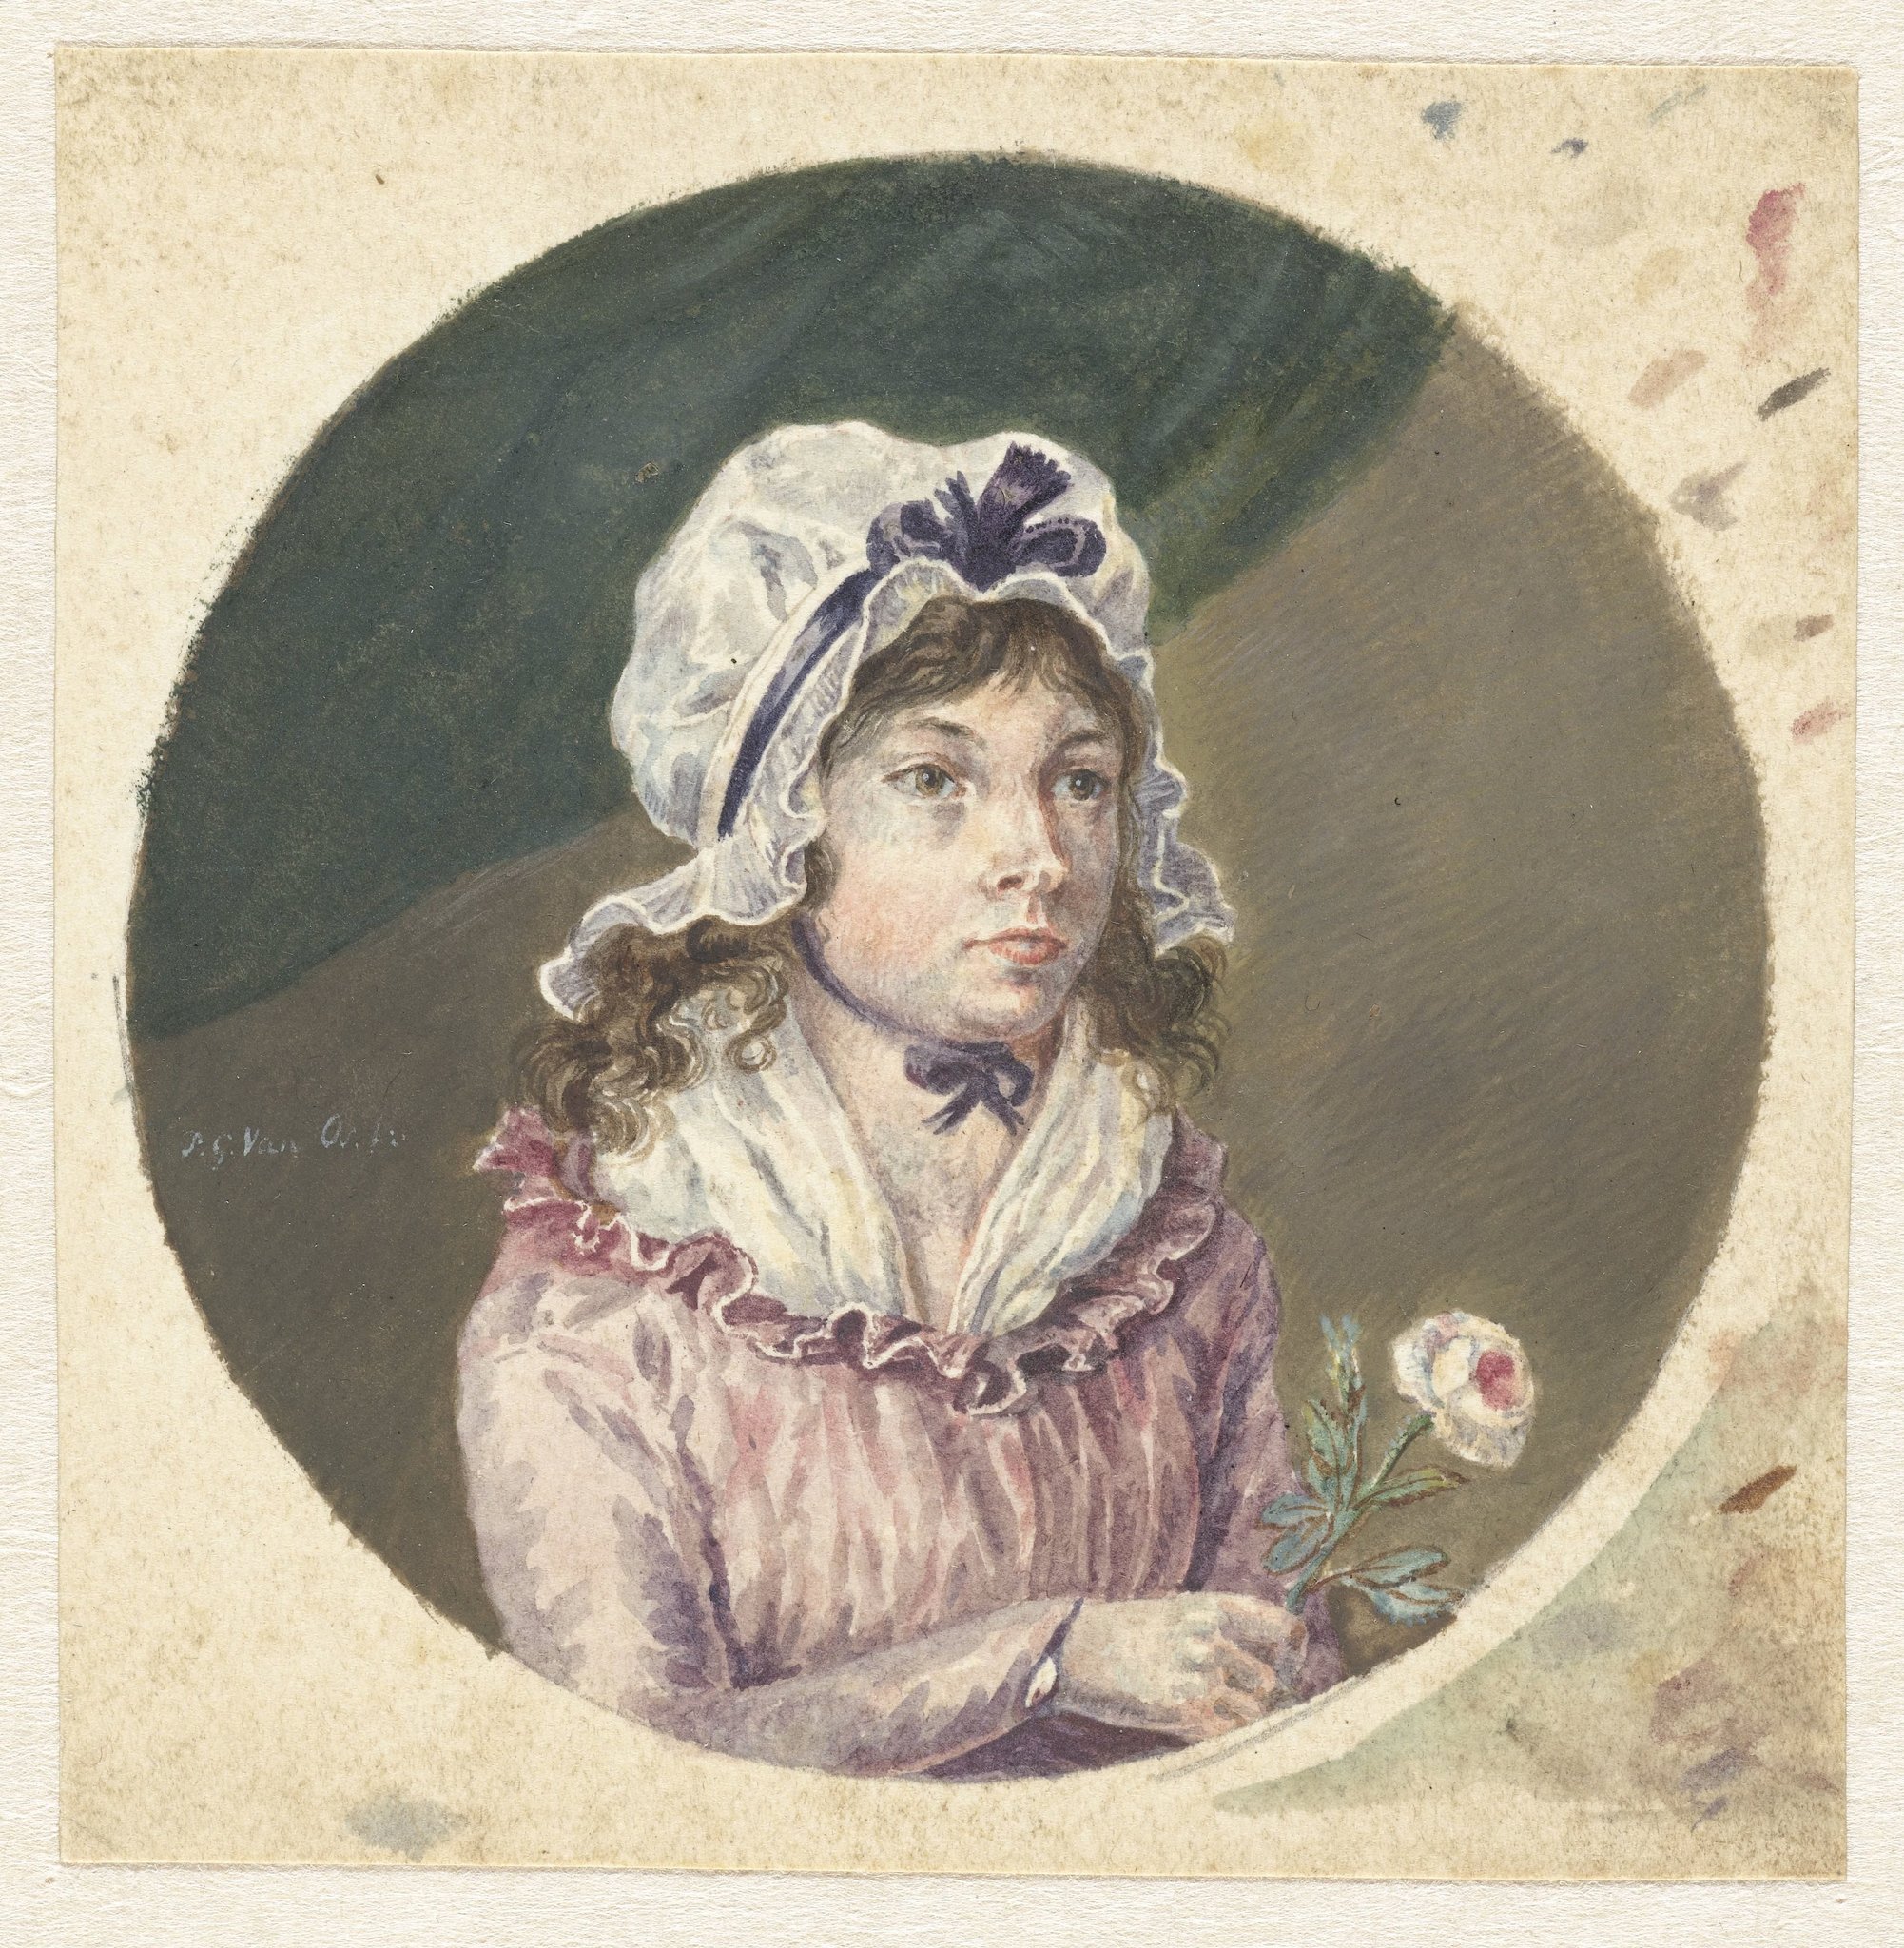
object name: drawing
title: Portret van Maria Margaretha van Os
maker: pieter gerardus van os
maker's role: draughtsman, painter, print maker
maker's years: 1776-1839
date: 1786-1839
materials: paint, gouache, paper, watercolor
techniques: brush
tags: maria margaretha van os, historical persons - bb - woman, portrait, self-portrait of artist, portrait, self-portrait of draughtsman